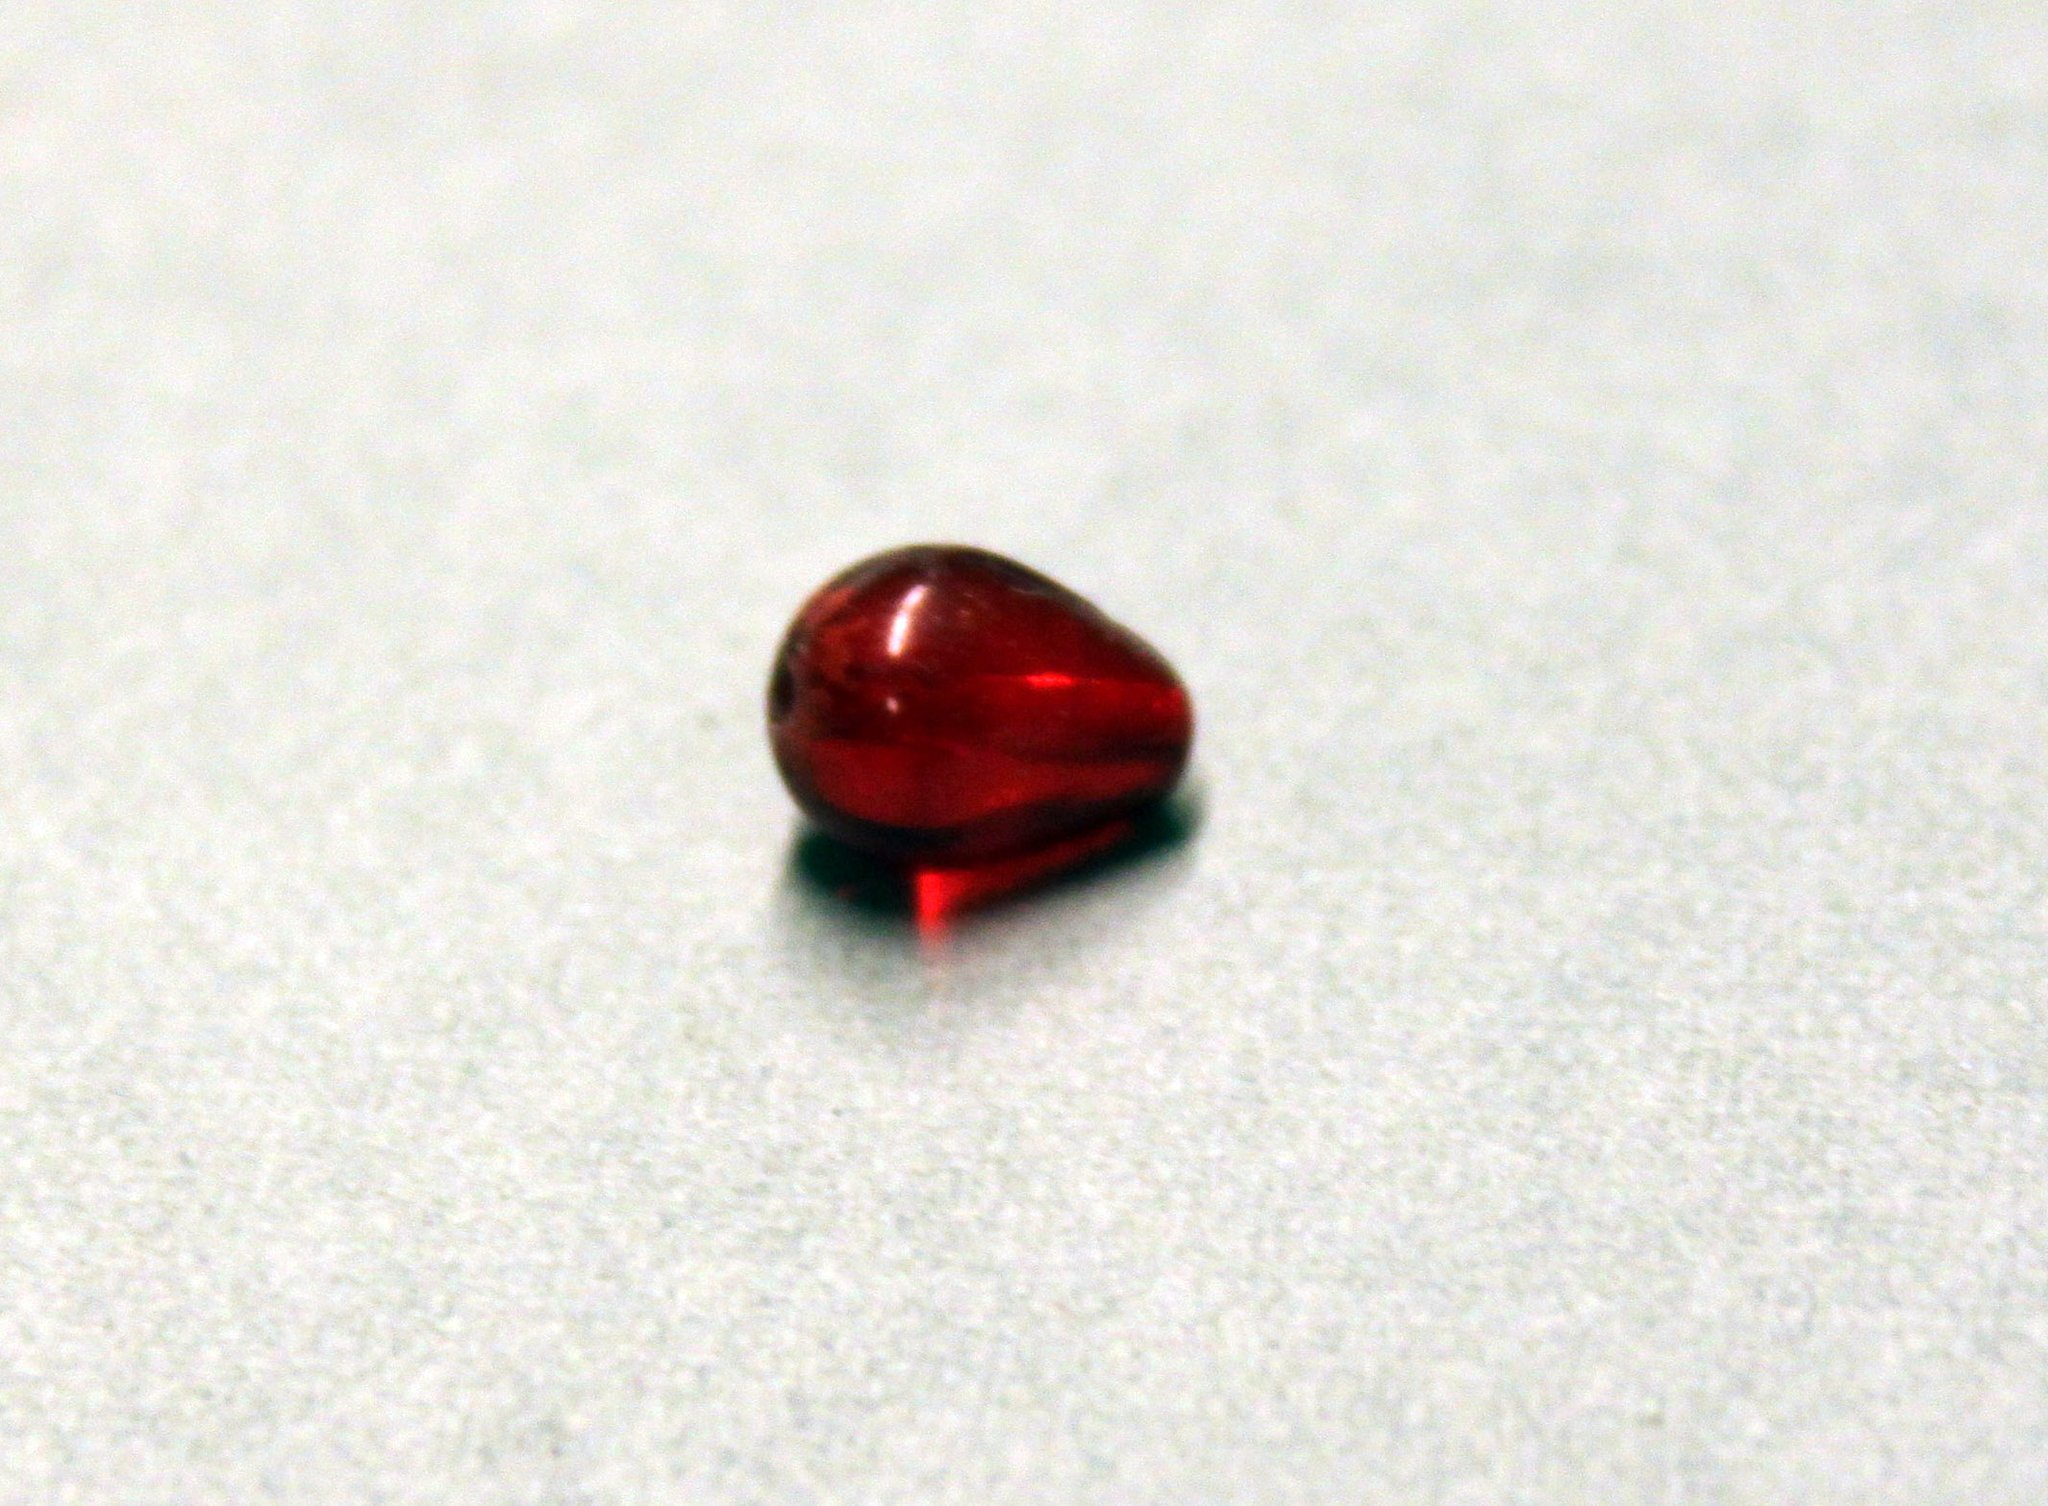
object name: bead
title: Beads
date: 701-1300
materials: glass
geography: iran